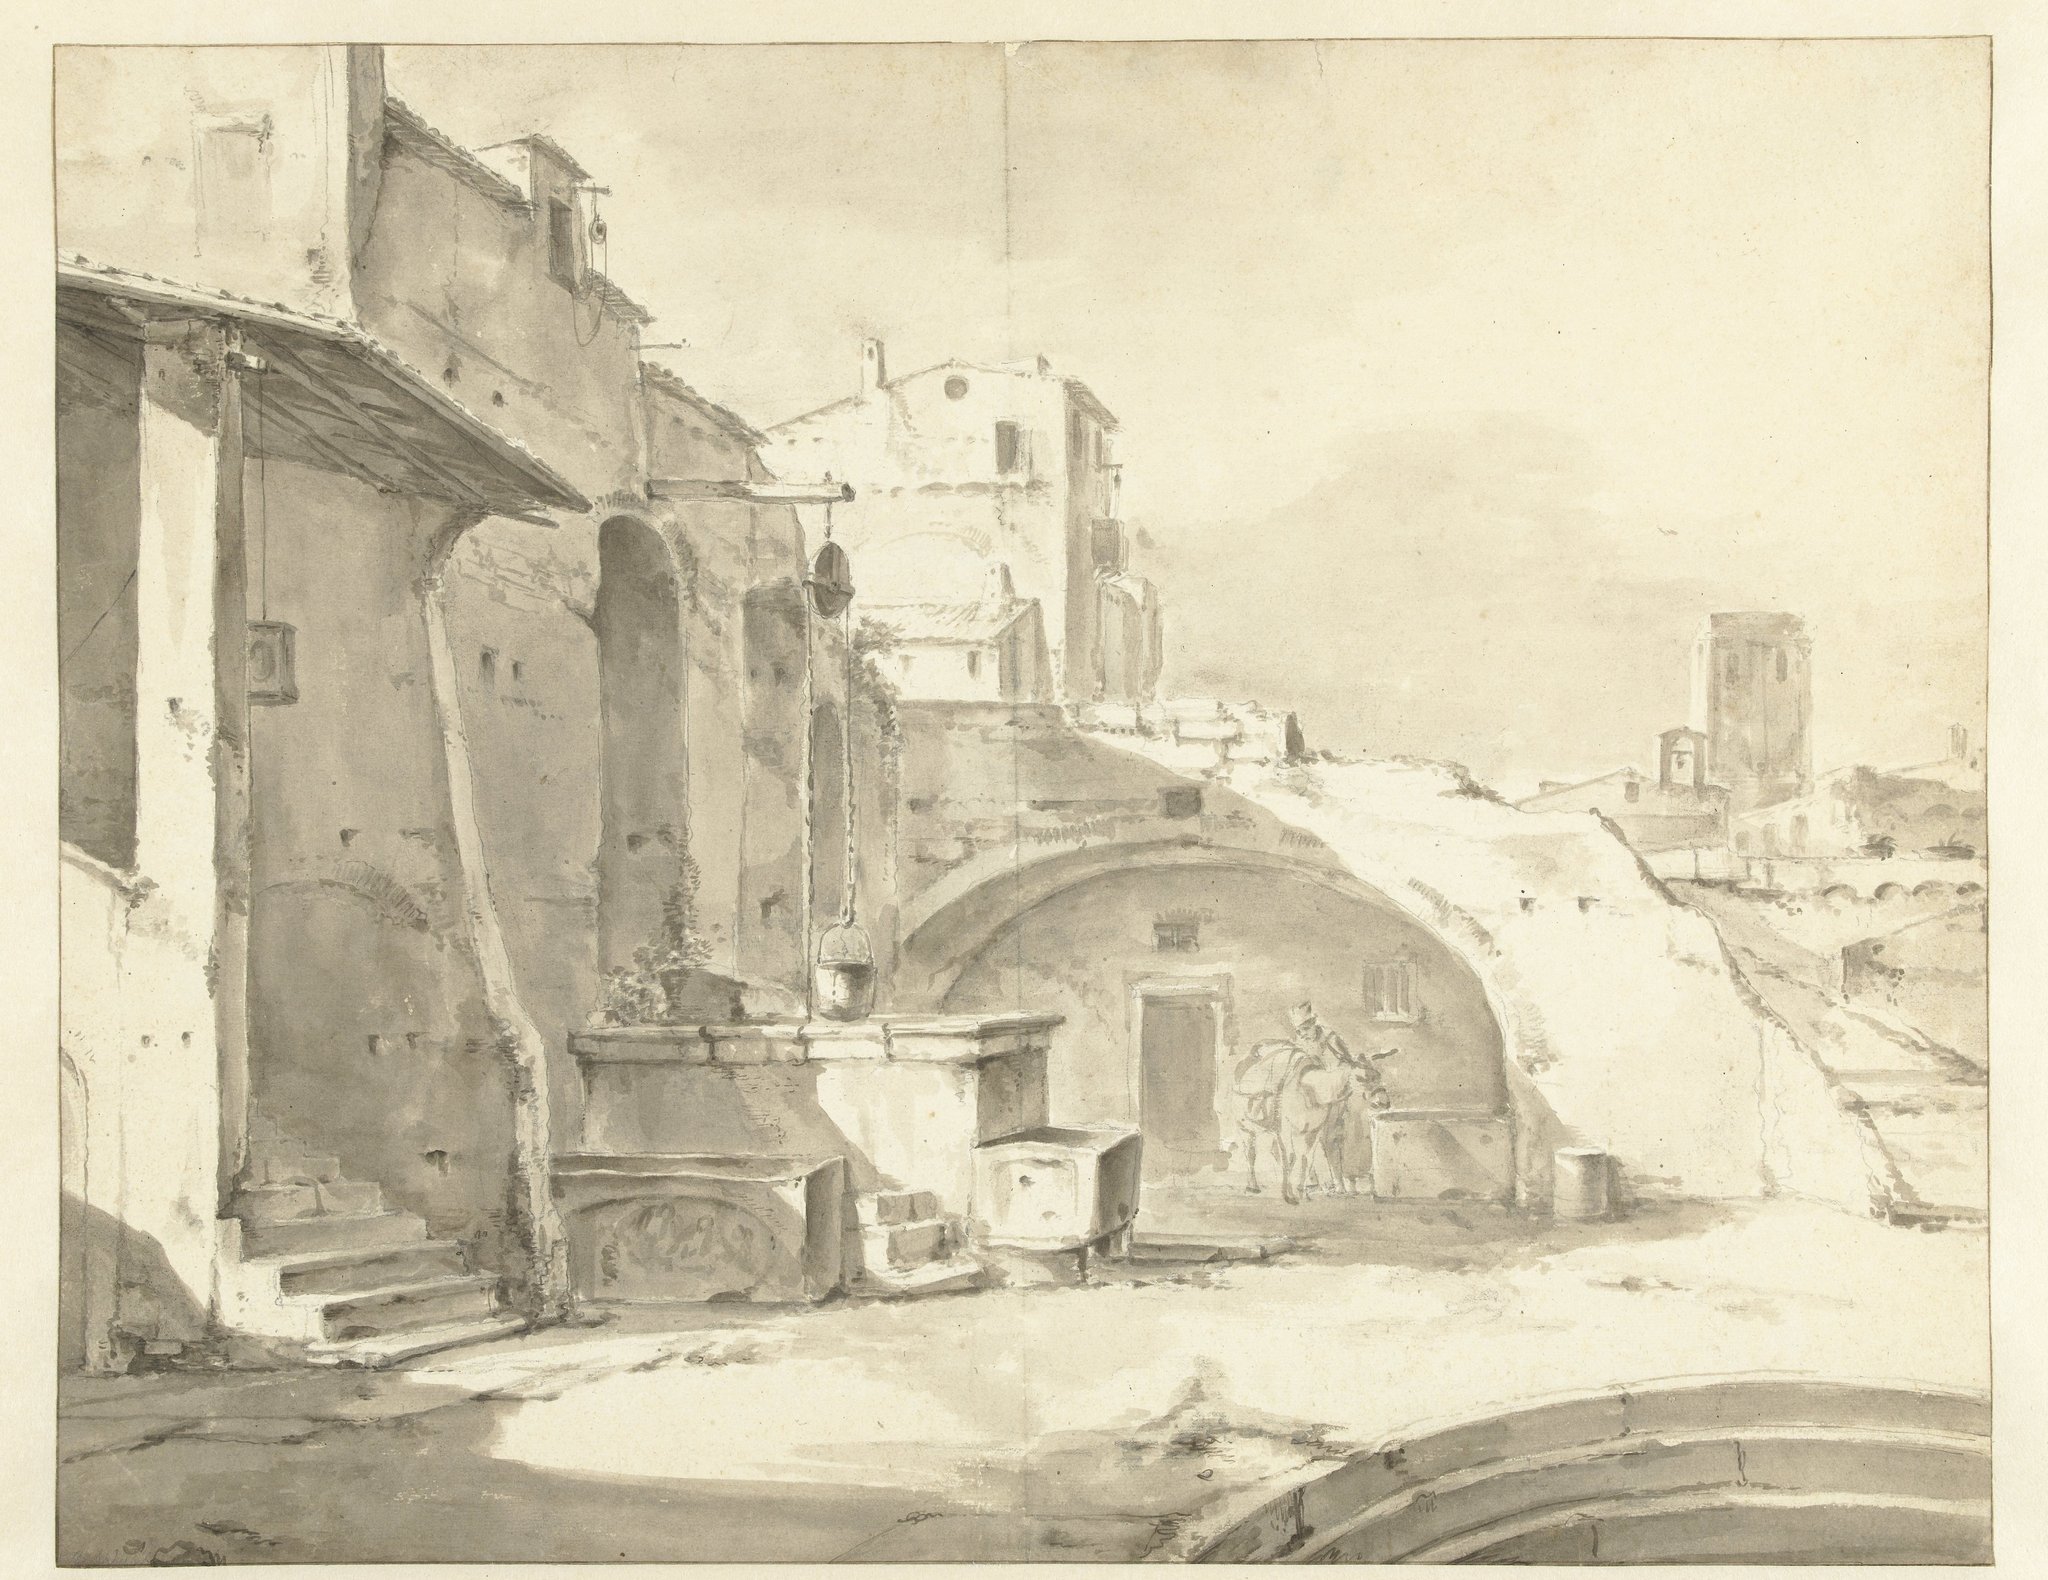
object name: drawing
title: Italiaanse ruïne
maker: thomas wijck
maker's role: draughtsman, painter, print maker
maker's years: 1616-1677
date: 1626-1677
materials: chalk, paper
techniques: brush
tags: urban housing, italy